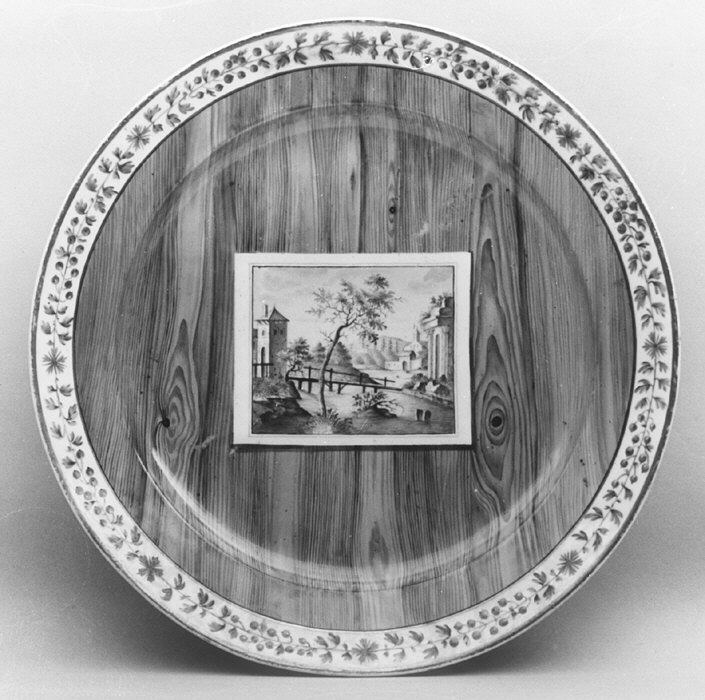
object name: plate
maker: nymphenburg porcelain manufactory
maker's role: manufactory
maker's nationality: german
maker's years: 1747-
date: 1780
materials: hard paste porcelain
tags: rivers,trees